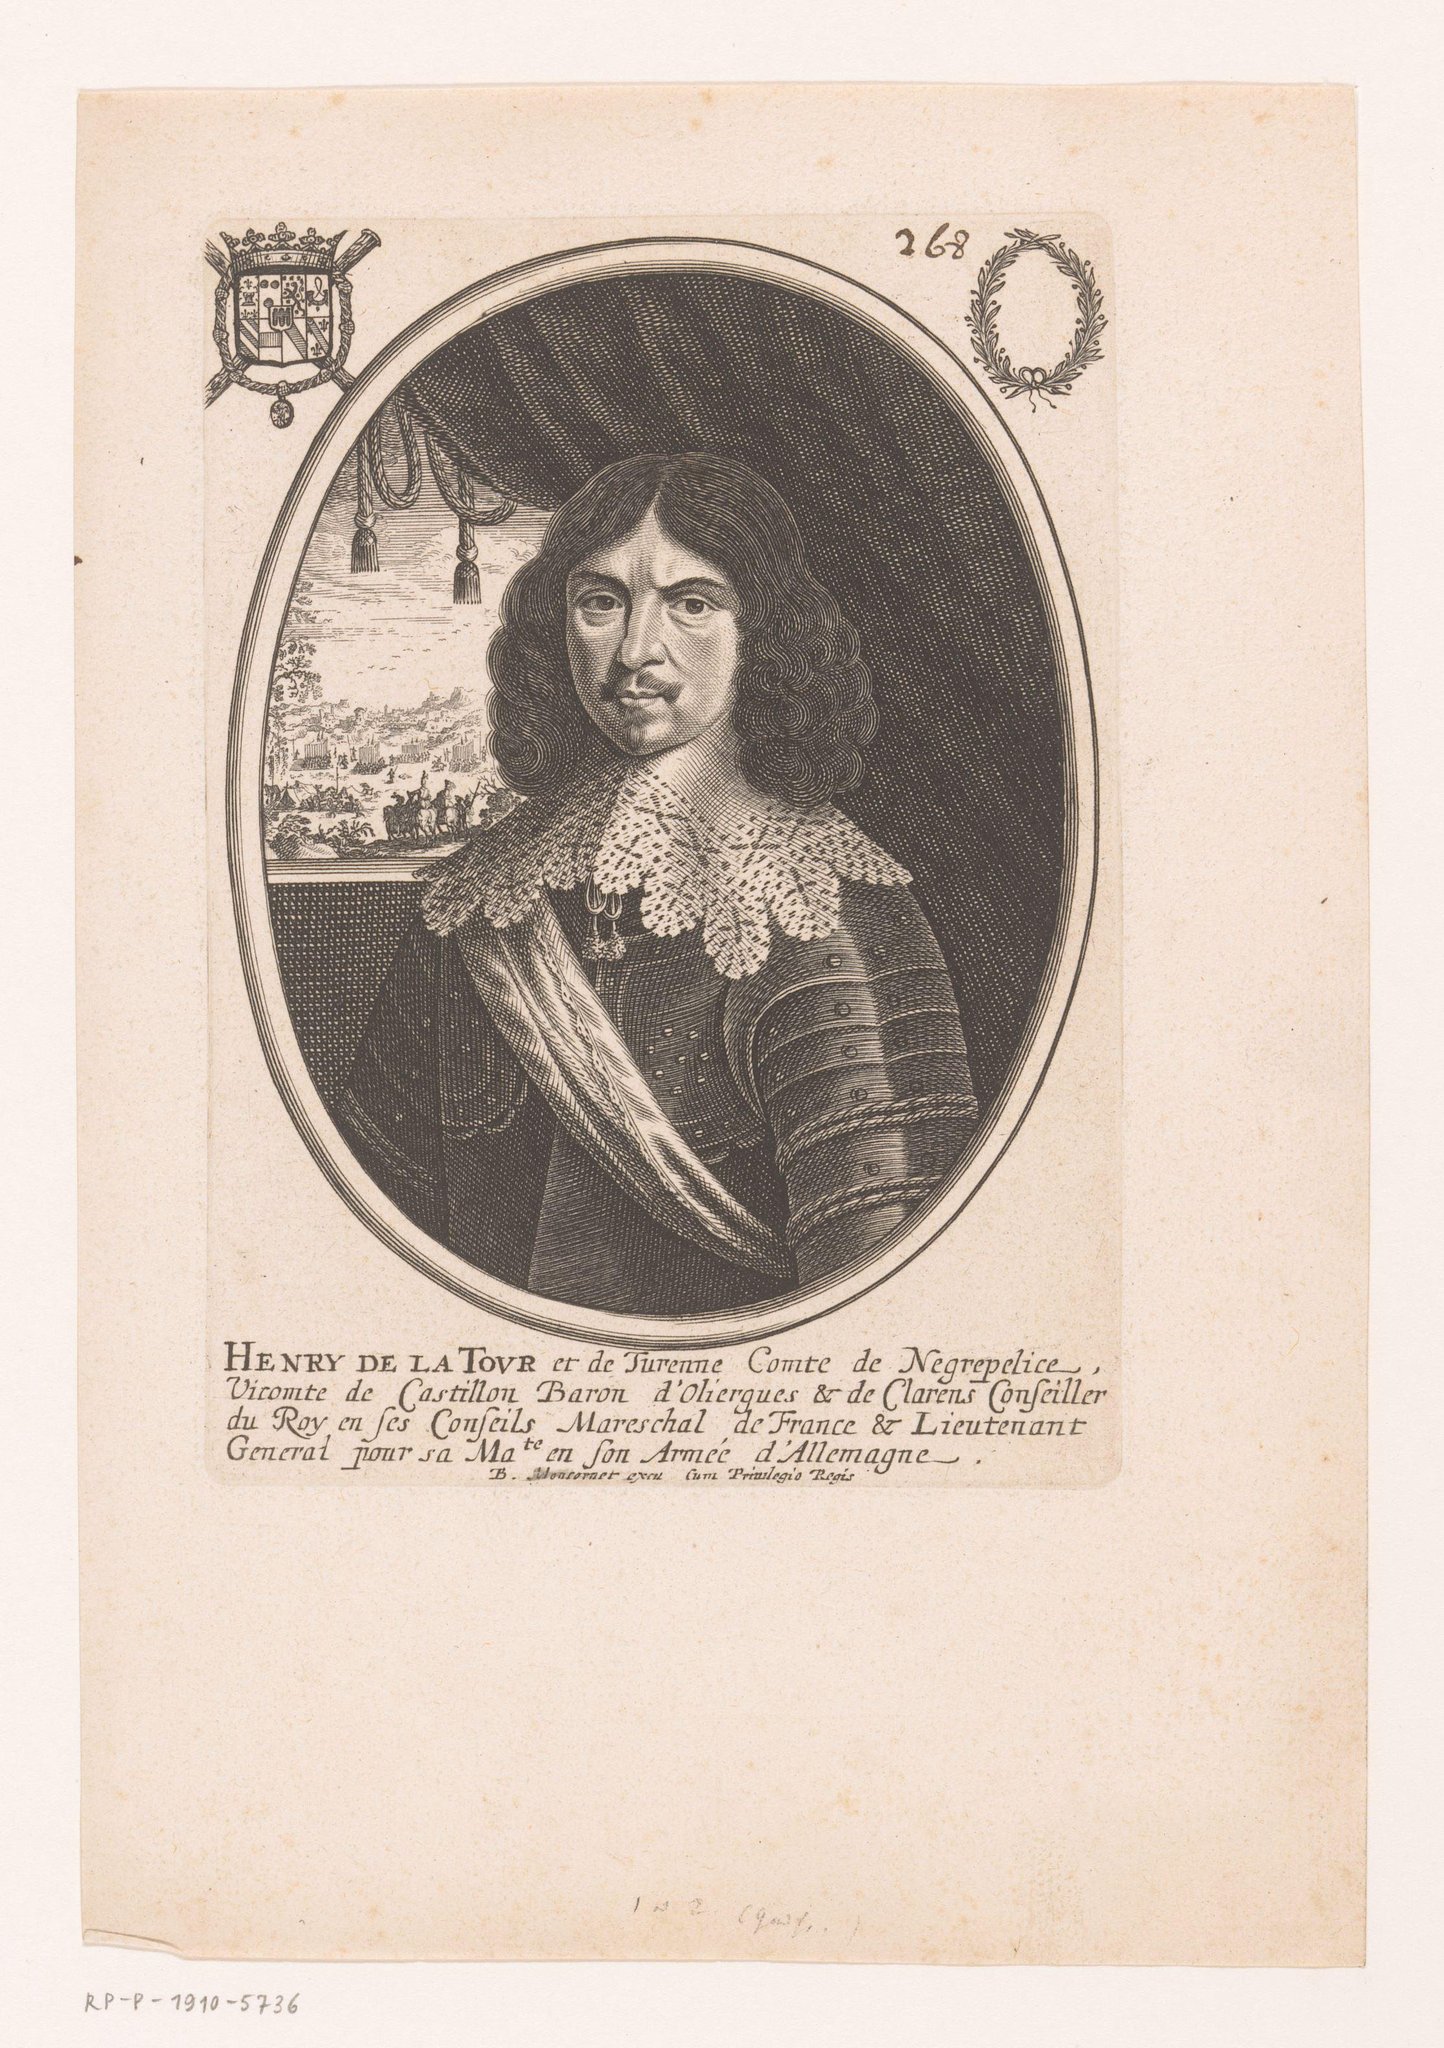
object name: print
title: Portret van Henri de La Tour d'Auvergne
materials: paper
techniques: engraving, etching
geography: france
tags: historical persons, armorial bearing, heraldry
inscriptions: collector's mark: Lugt 2228, number: ‘268’